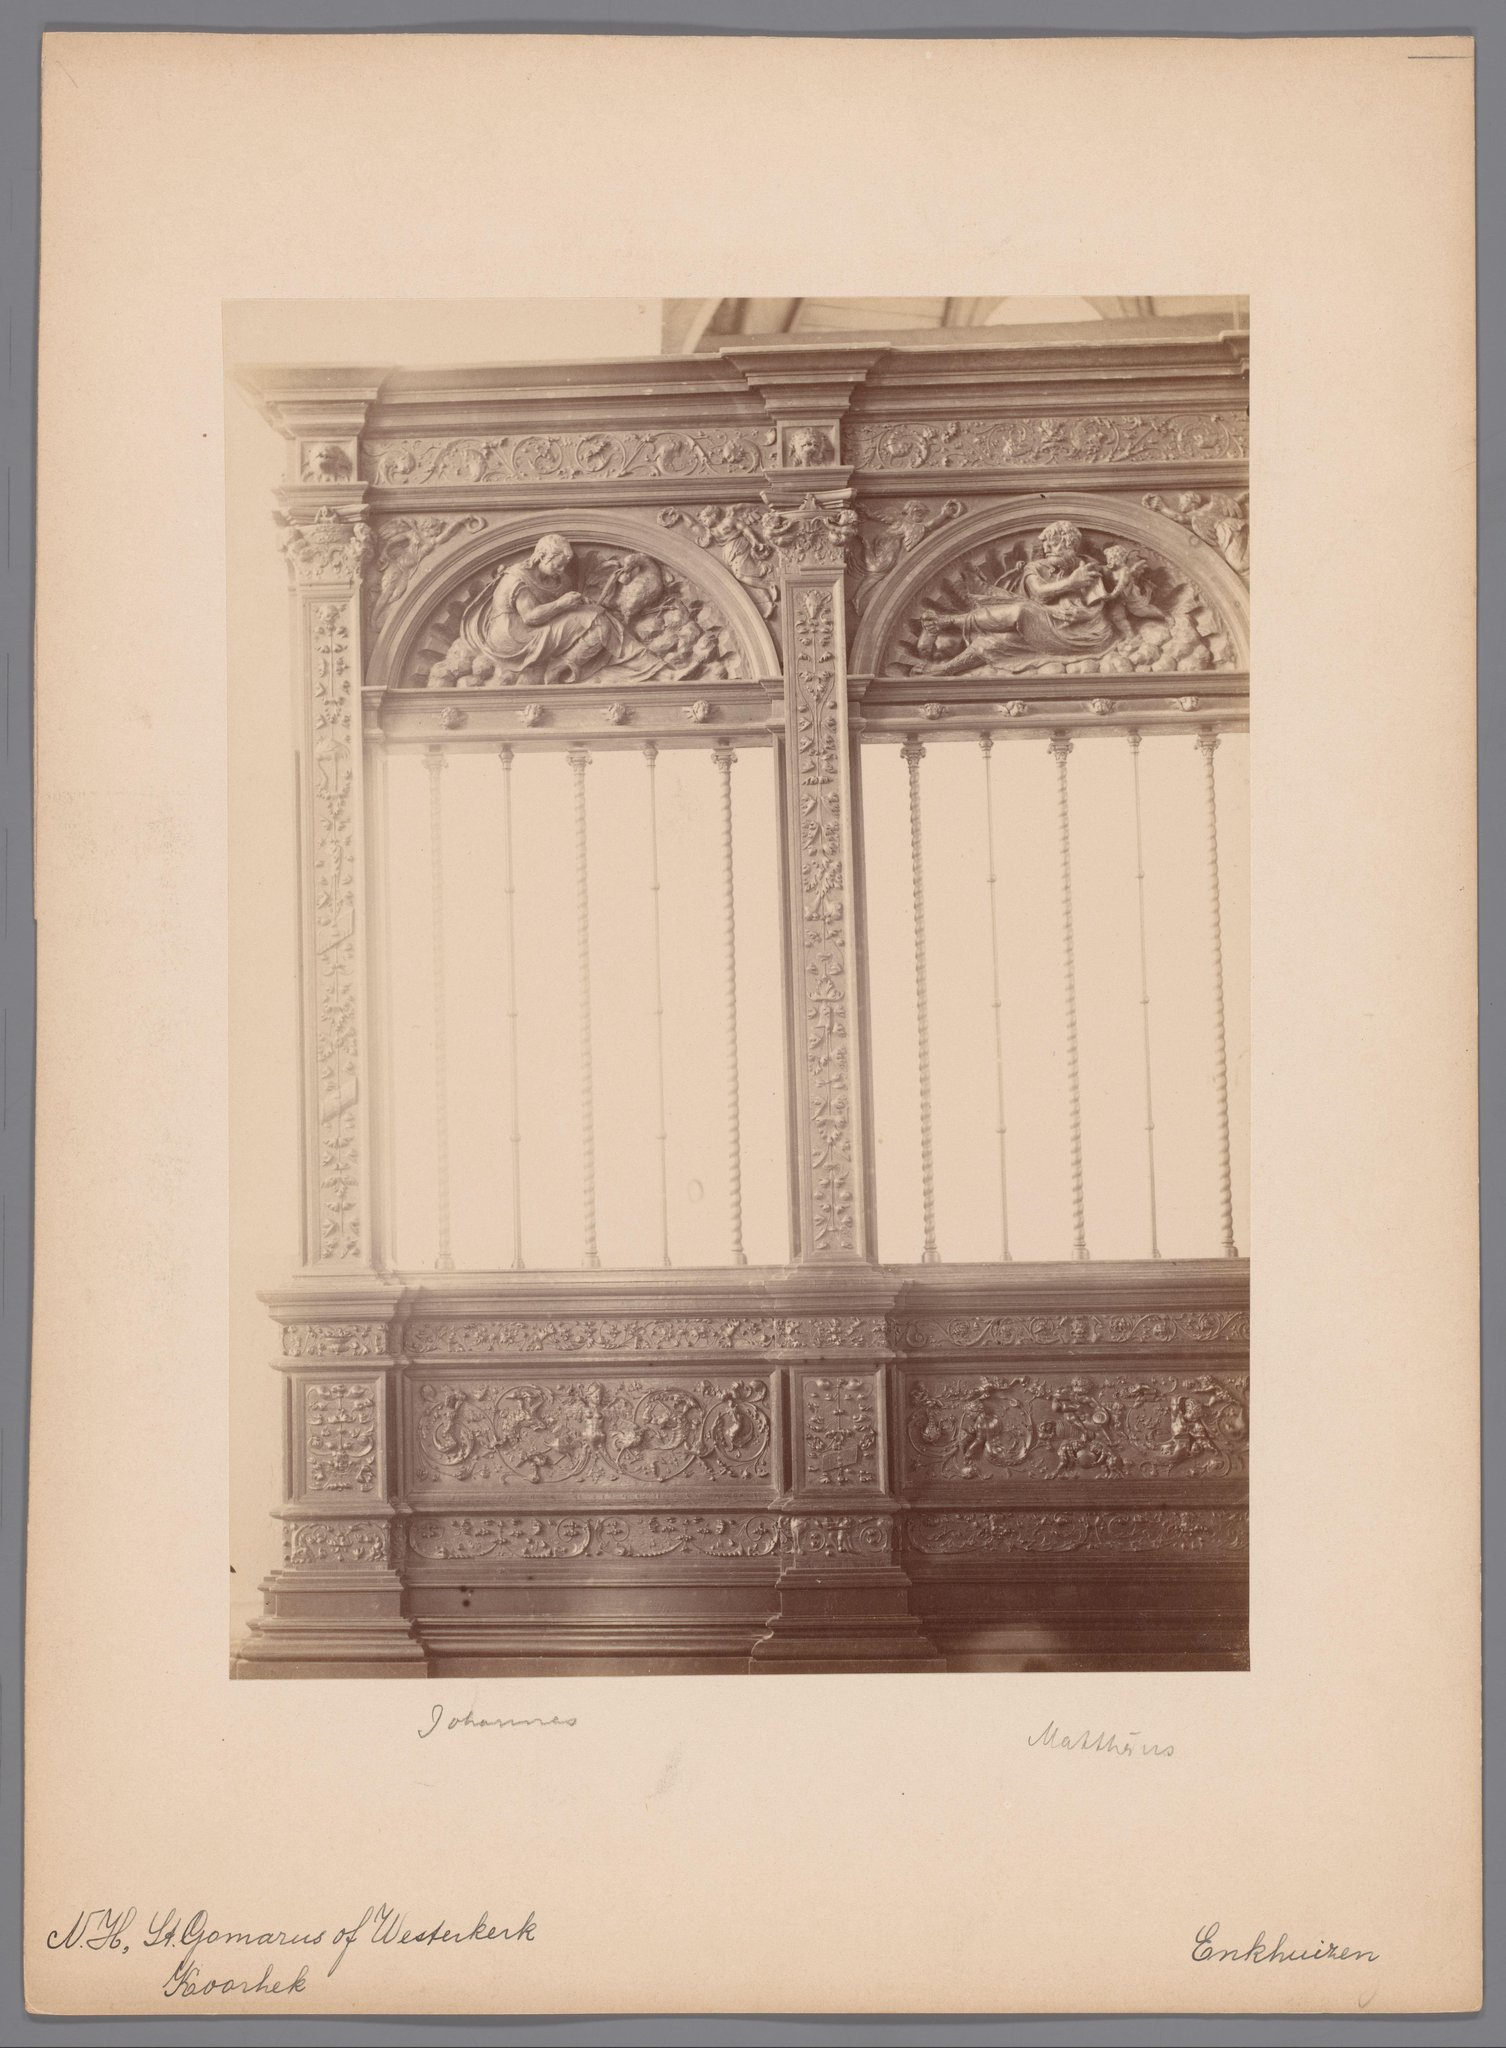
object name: photograph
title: Koorhek in de Westerkerk te Enkhuizen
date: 1880-1895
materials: cardboard, photographic support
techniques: albumen print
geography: westerkerk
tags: interior of church, choir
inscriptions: annotation: ‘Johannus/ Matthius/ N.H, st. Gomarus of Westerkerk/ Koorhek/ Enkhuizen’, annotation: ‘Koorhek in de Westerkerk te Enkhuizen’